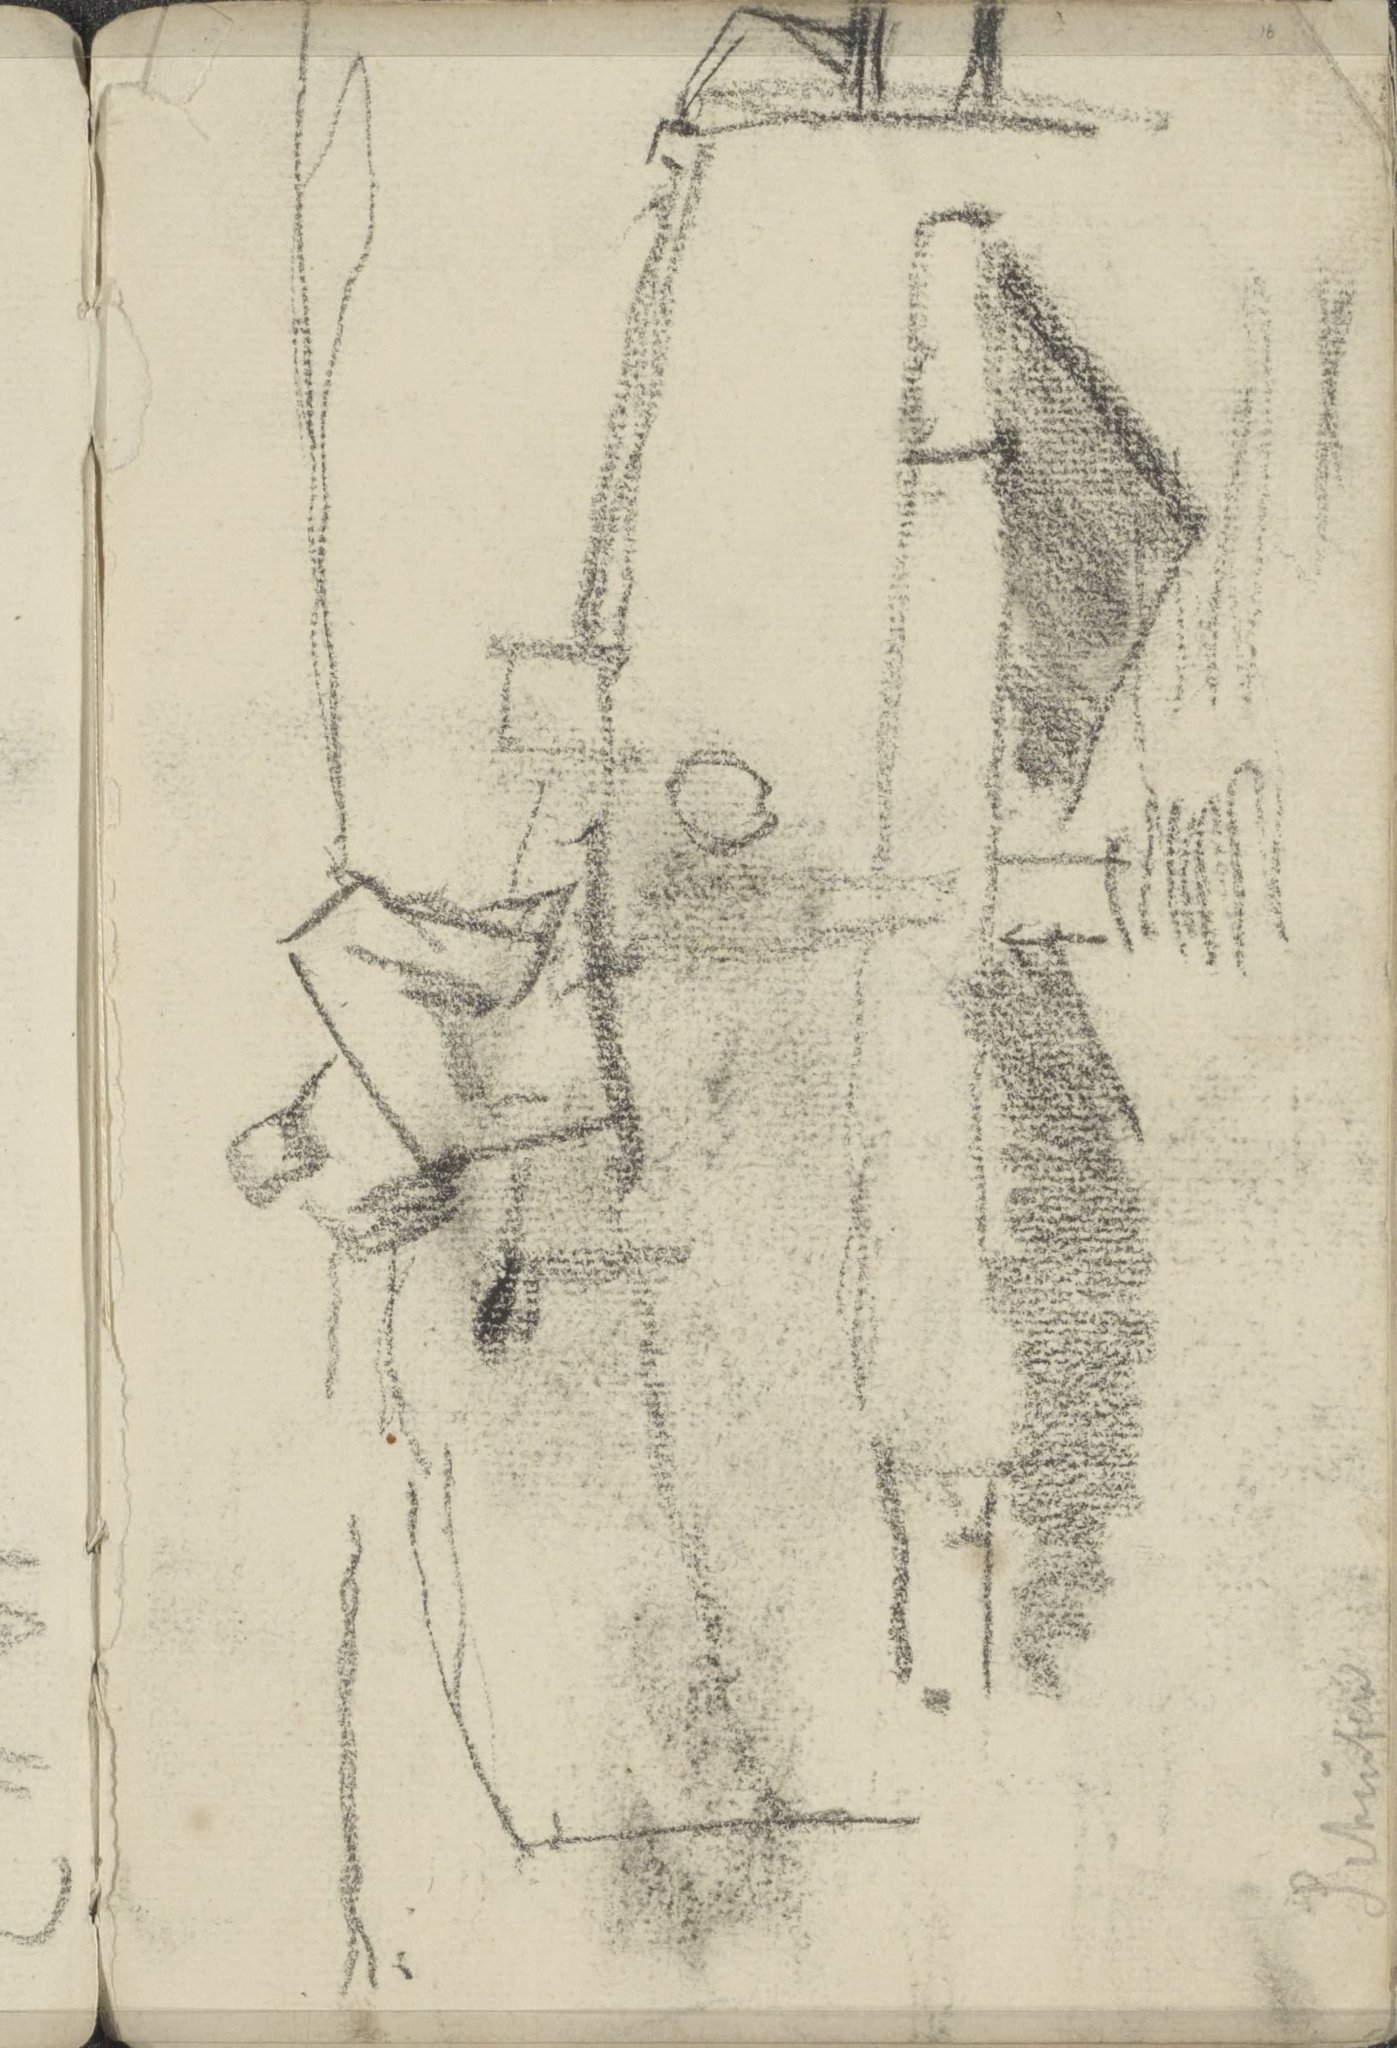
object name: sketchbook leaf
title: Schuiten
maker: george hendrik breitner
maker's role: draughtsman, painter, print maker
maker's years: 1857-1923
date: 1867-1923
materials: chalk, paper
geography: amsterdam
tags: adult man, ships (in general)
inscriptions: annotation: ‘Schuiten’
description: Pagina 16 uit een schetsboek met 10 bladen.